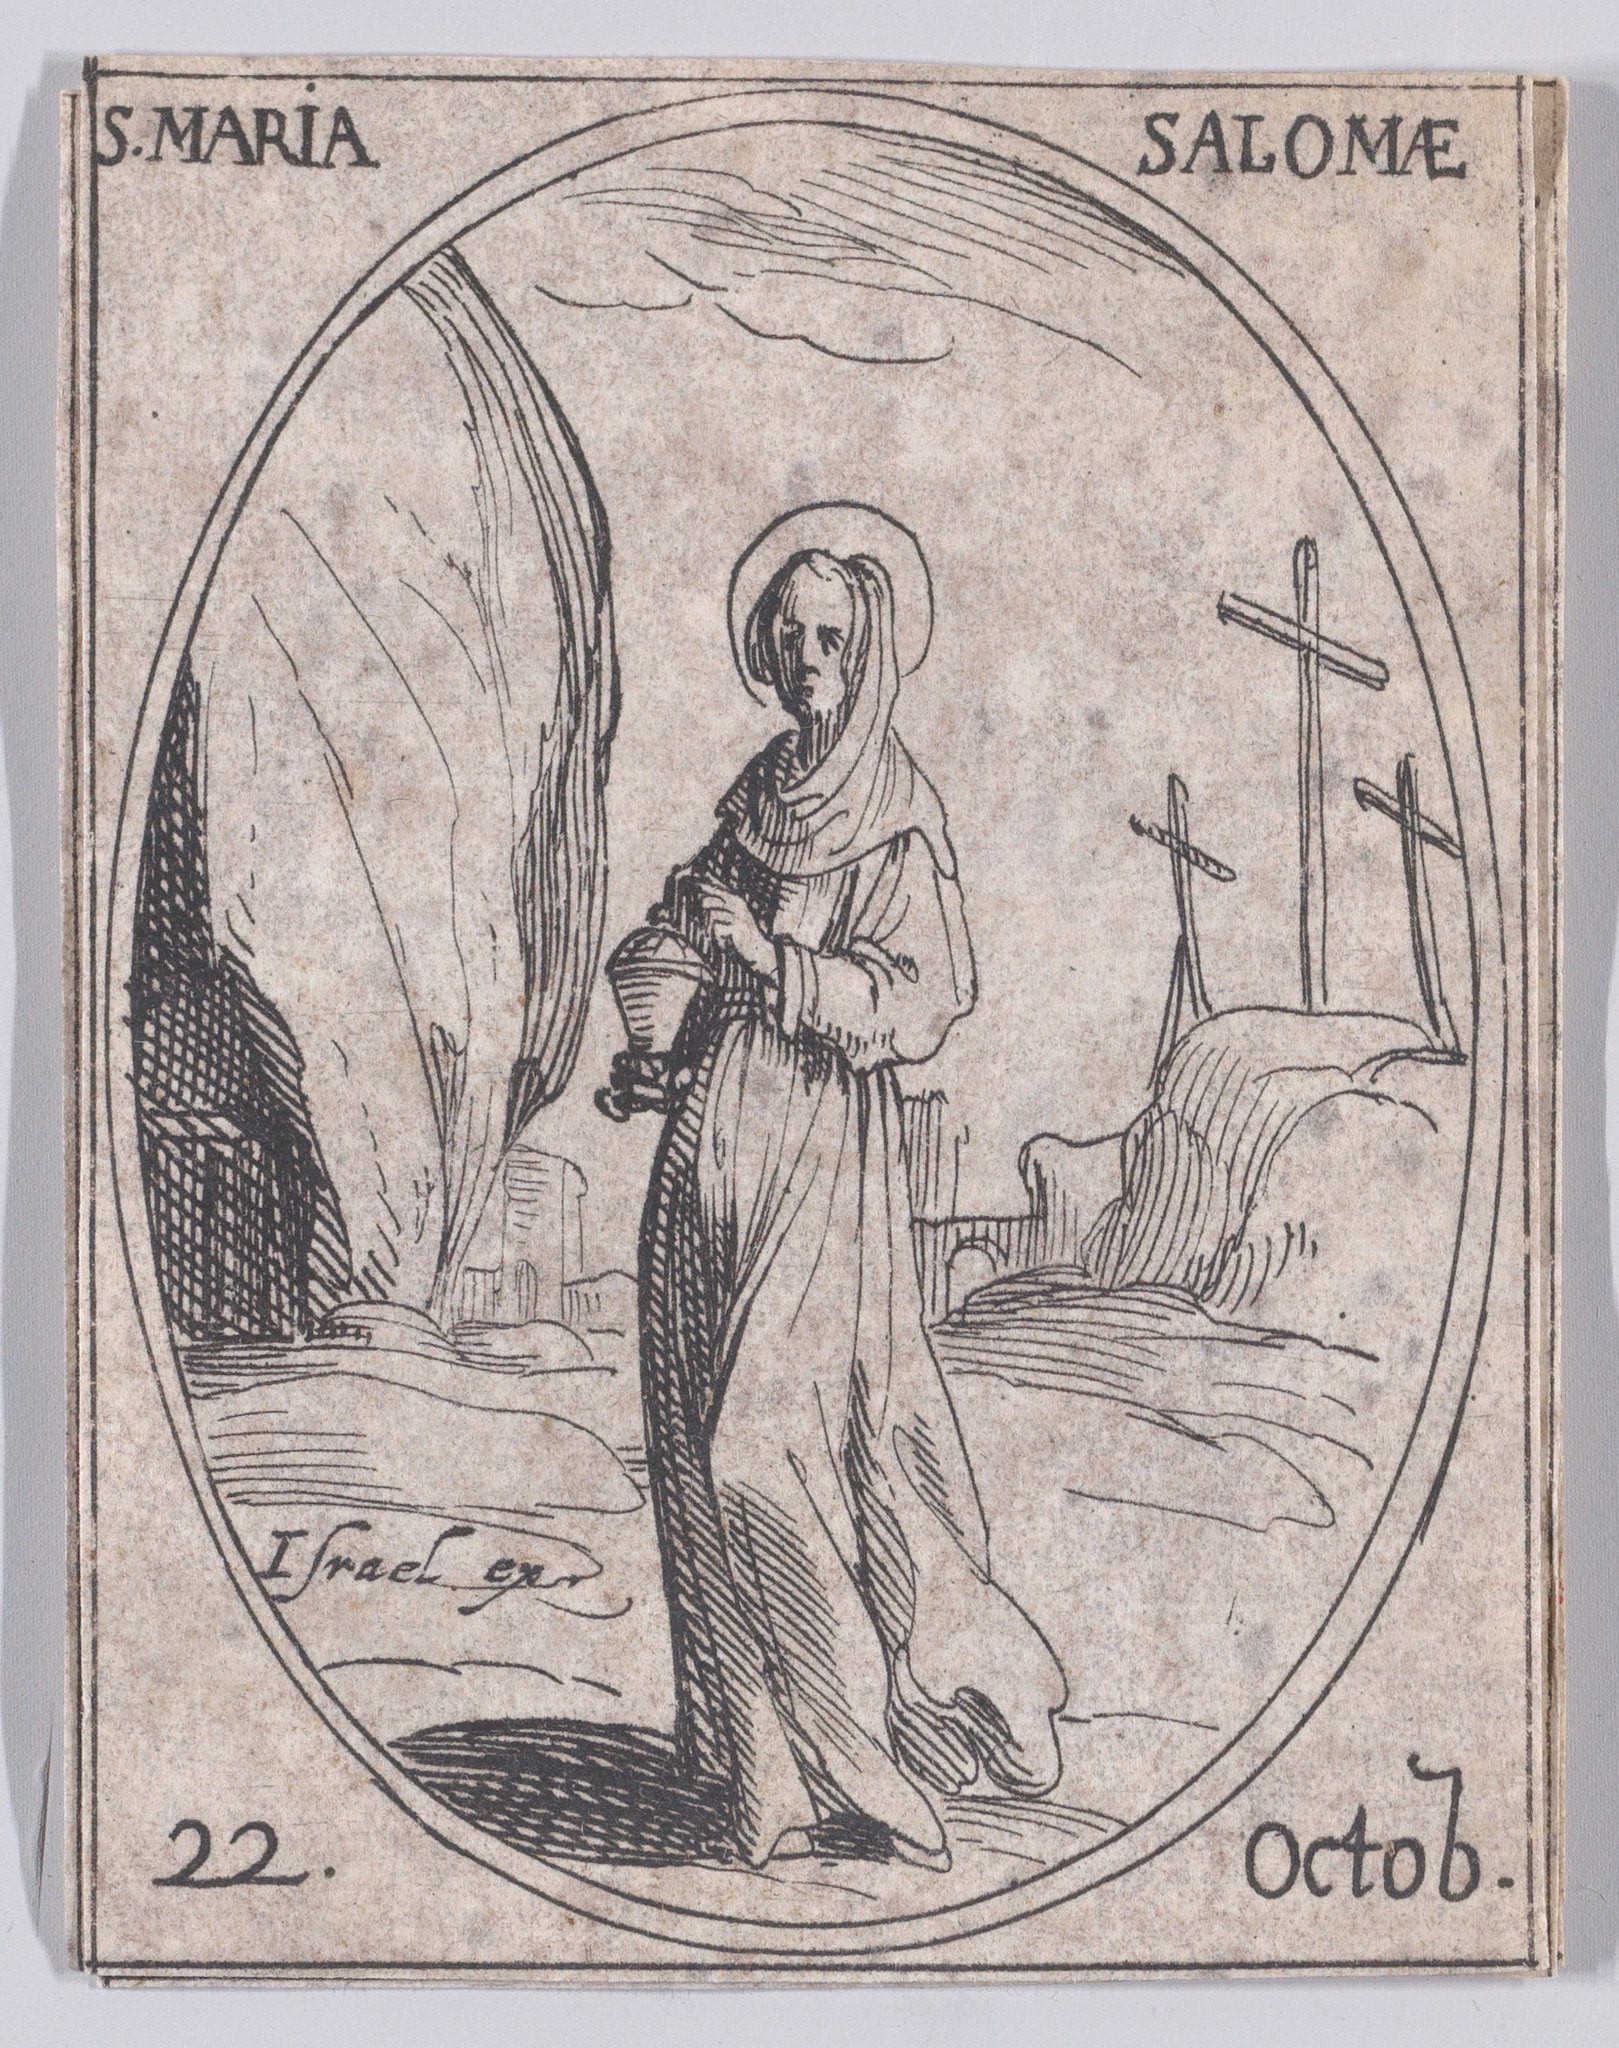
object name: print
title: Ste. Maria Salomé (St. Mary Salome), October 22nd, from "Les Images De Tous Les Saincts et Saintes de L'Année" (Images of All of the Saints and Religious Events of the Year)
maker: jacques callot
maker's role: artist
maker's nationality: french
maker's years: 1592-1635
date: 1636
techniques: etching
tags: women,saints